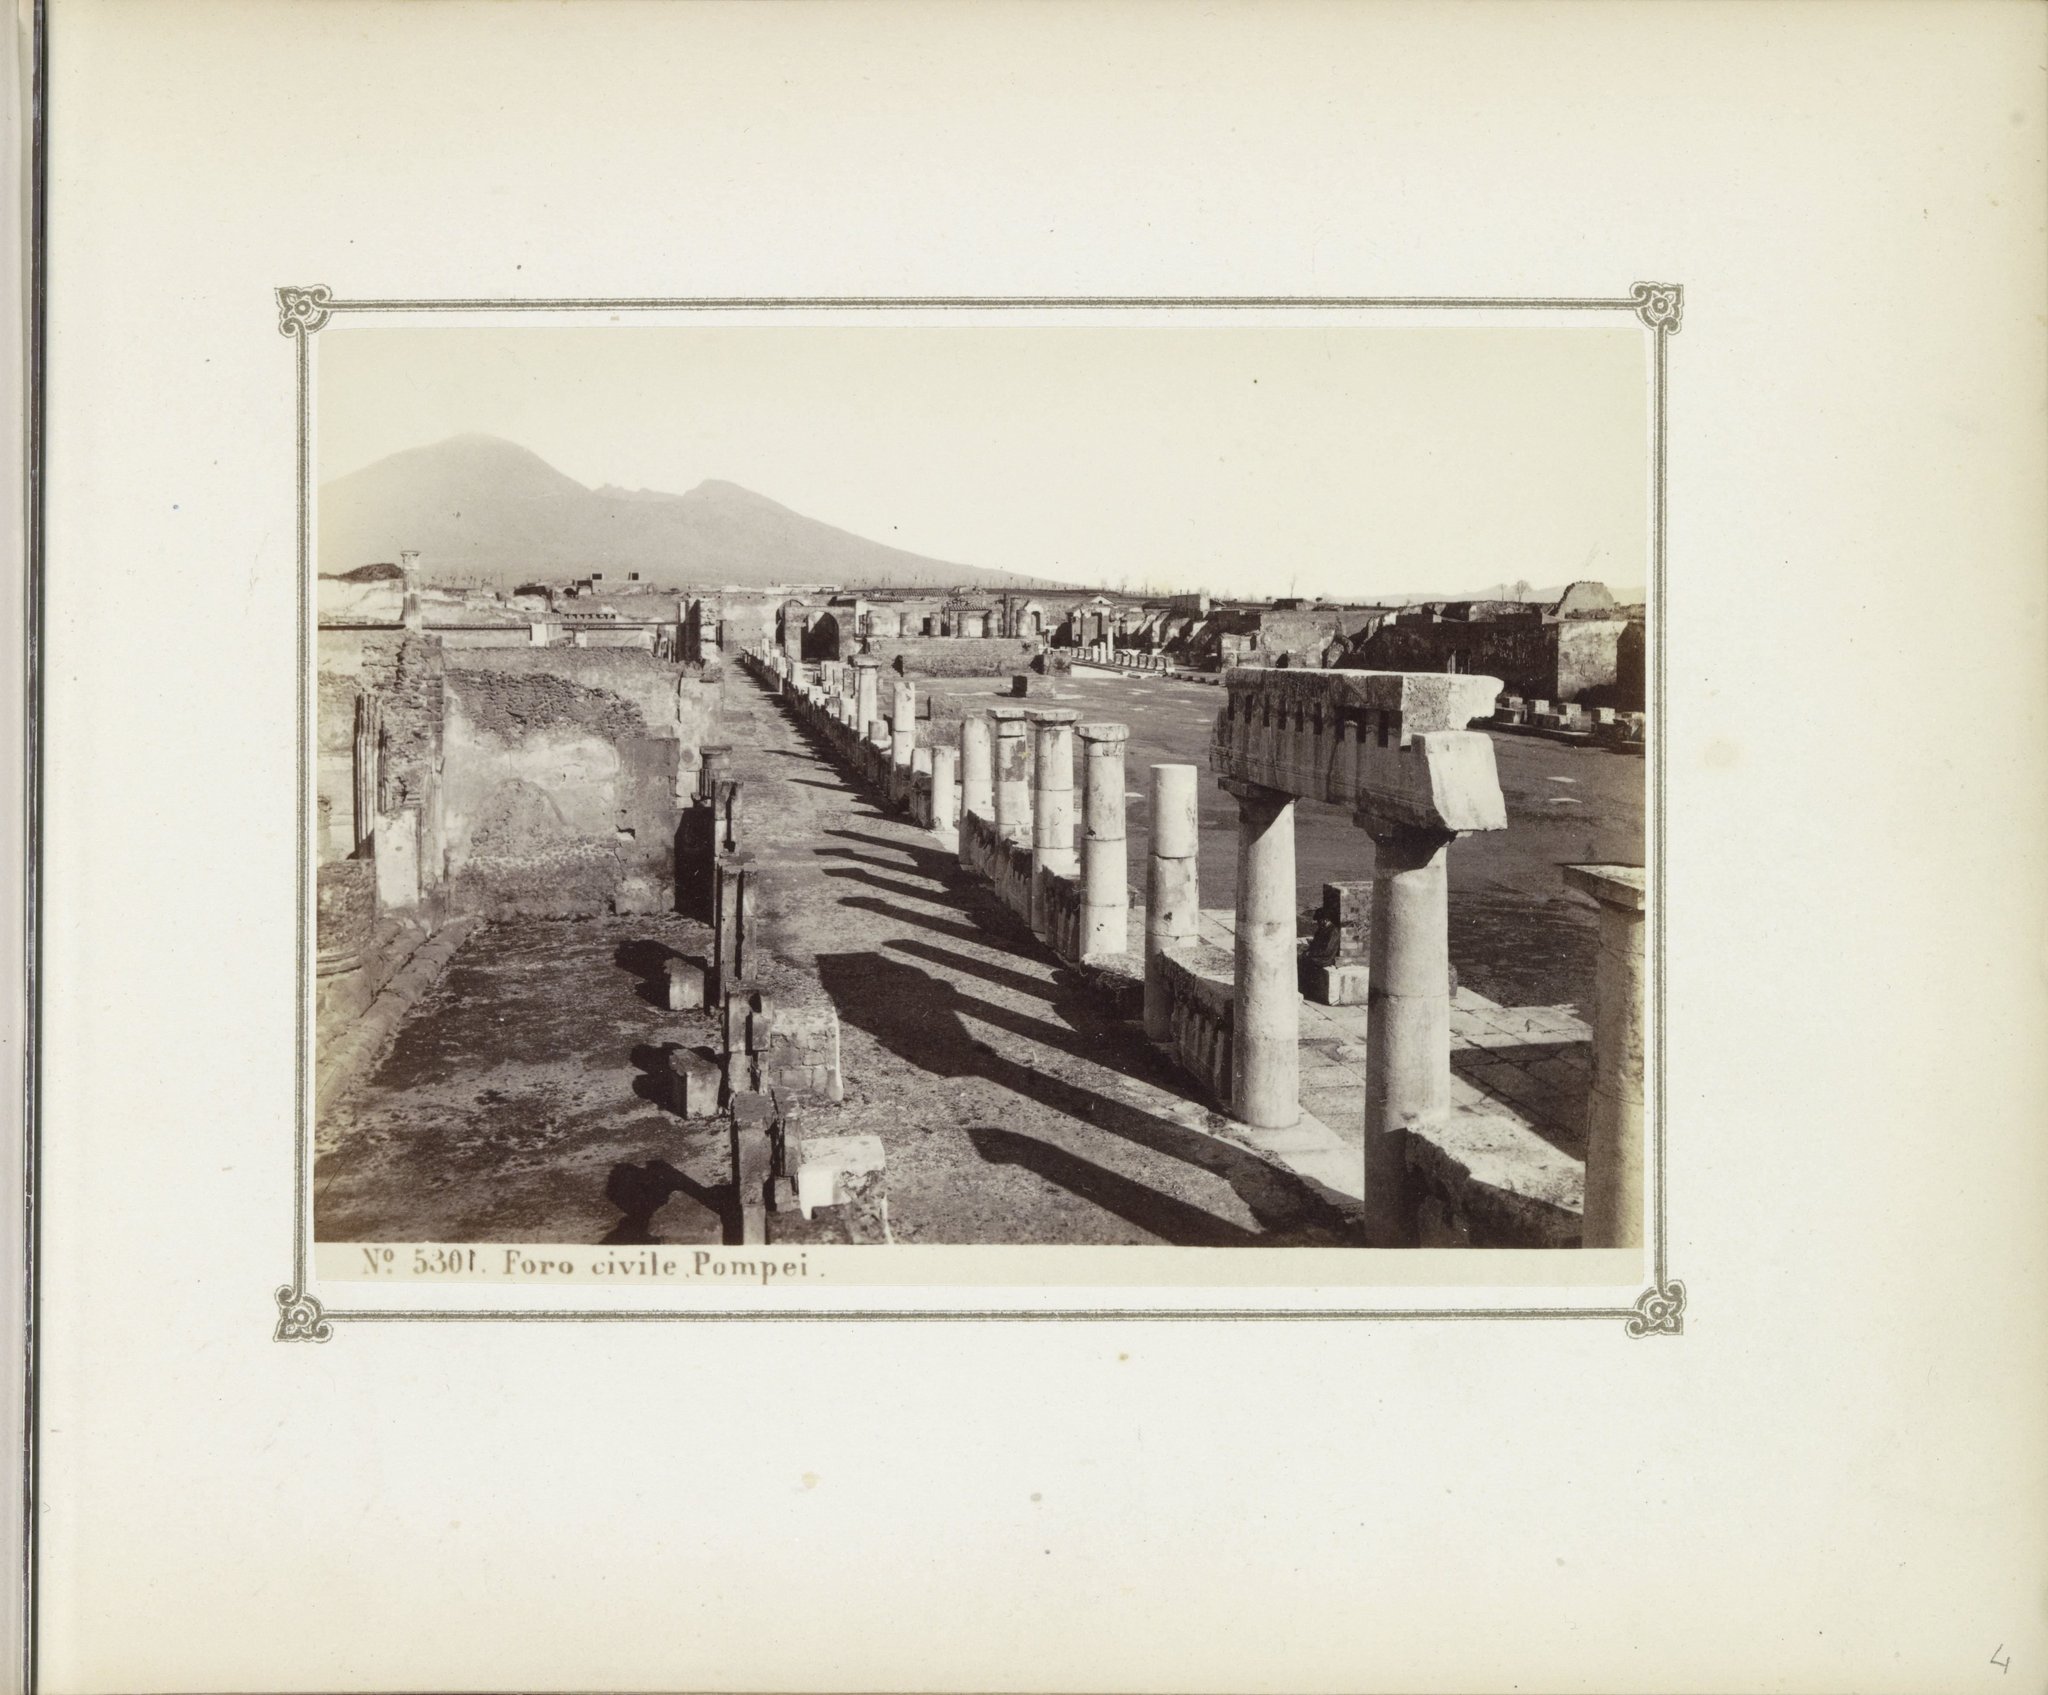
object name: photograph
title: Foro civile. Pompei.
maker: giorgio sommer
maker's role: fotograaf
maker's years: 1834-1914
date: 1860-1900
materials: paper, photographic support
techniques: albumen print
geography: pompeii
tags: square, place, circus, etc., excavation ~ archaeology, volcano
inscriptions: number: ‘5301’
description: Onderdeel van Fotoalbum met opnames van opgravingen in Pompeï door Giorgio Sommer.